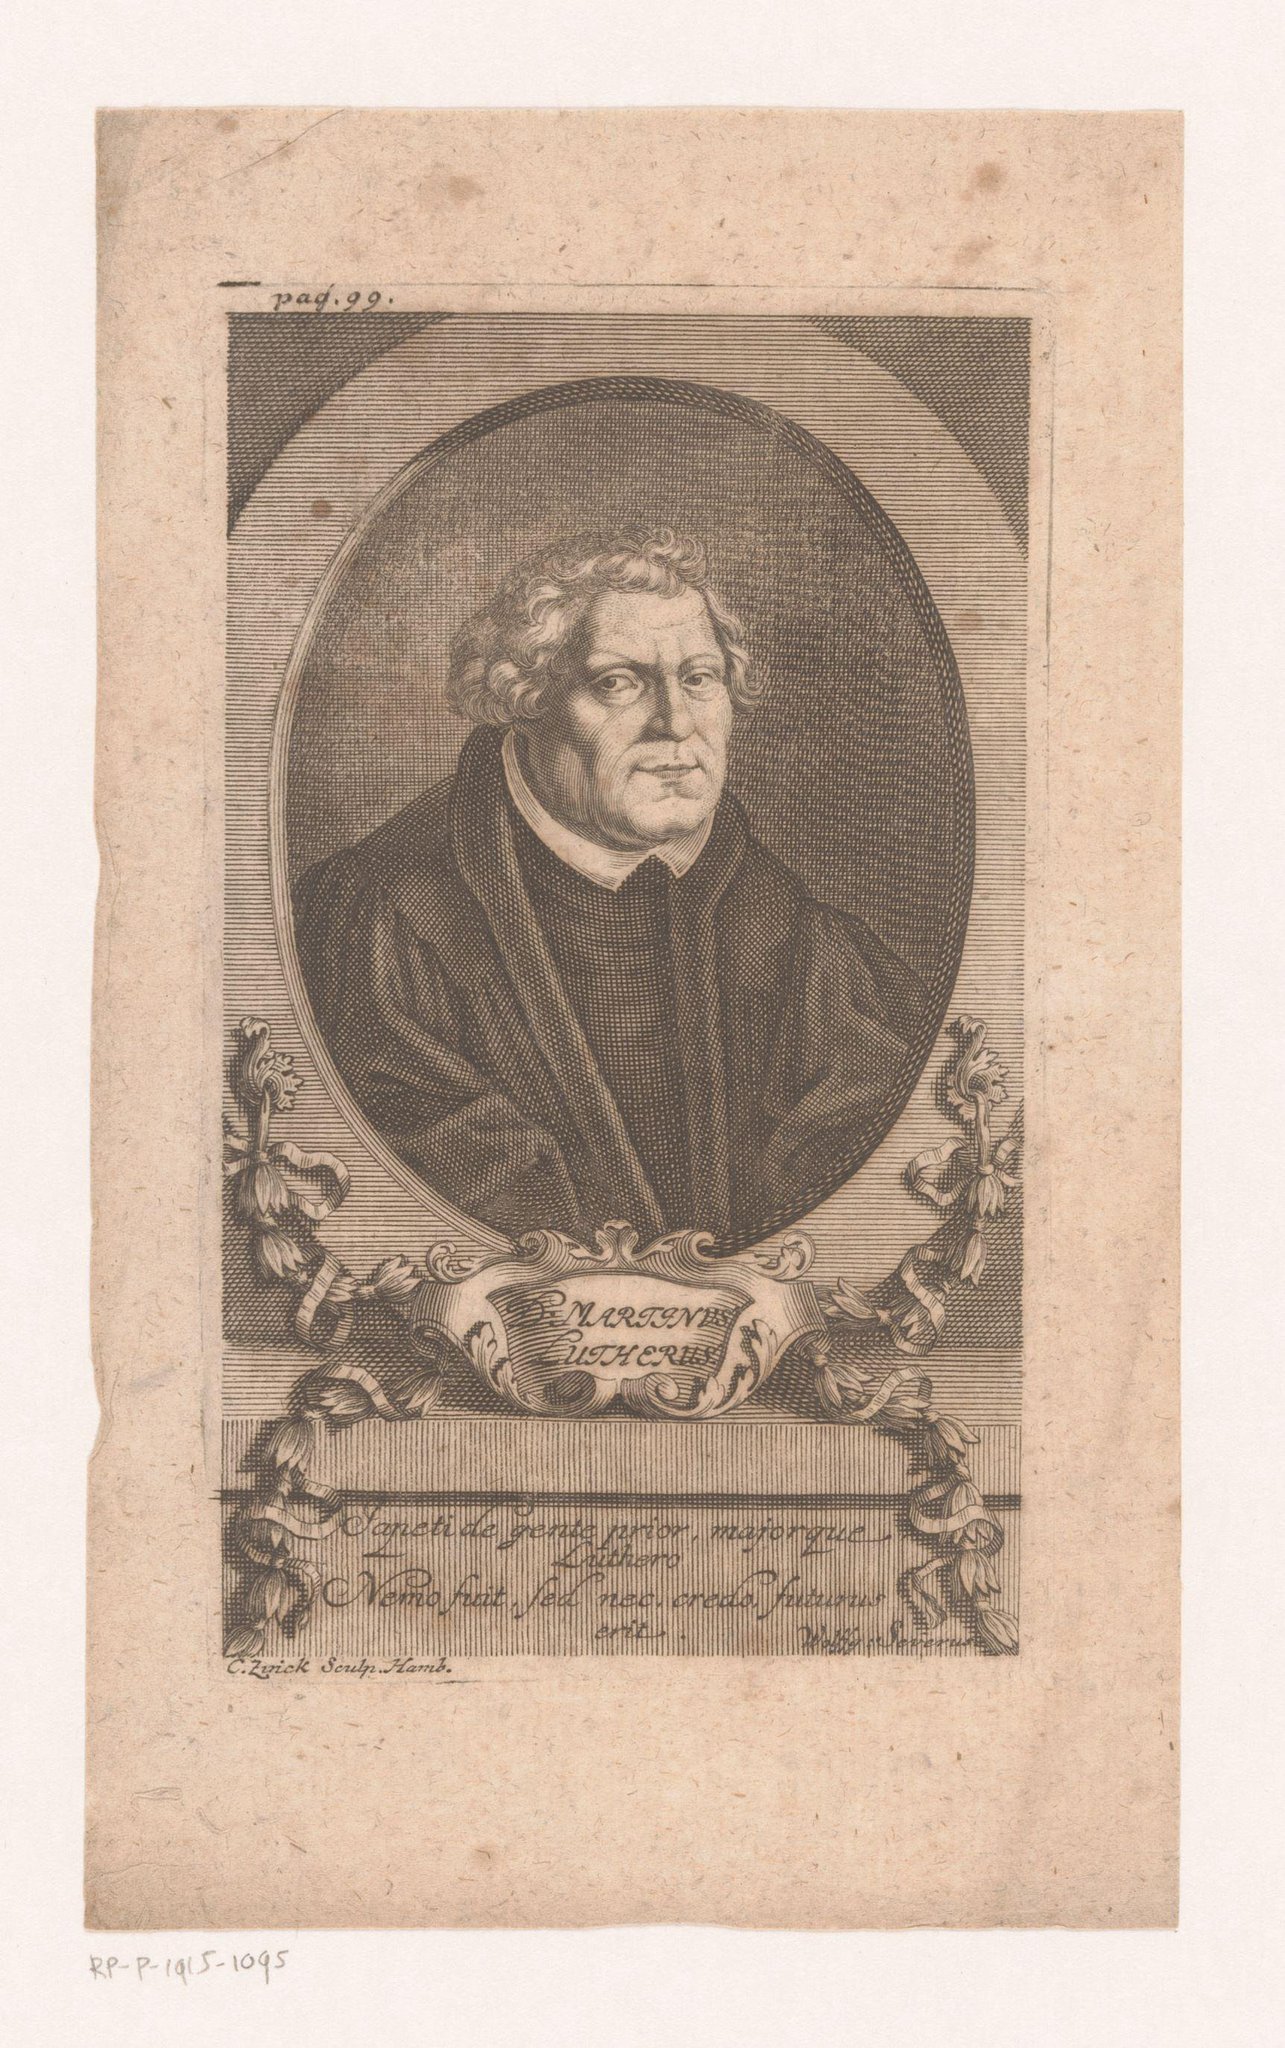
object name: book illustration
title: Portret van Martin Luther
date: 1700-1799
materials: paper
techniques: engraving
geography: hamburg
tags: priest, martin luther, historical persons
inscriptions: collector's mark: Lugt 2228